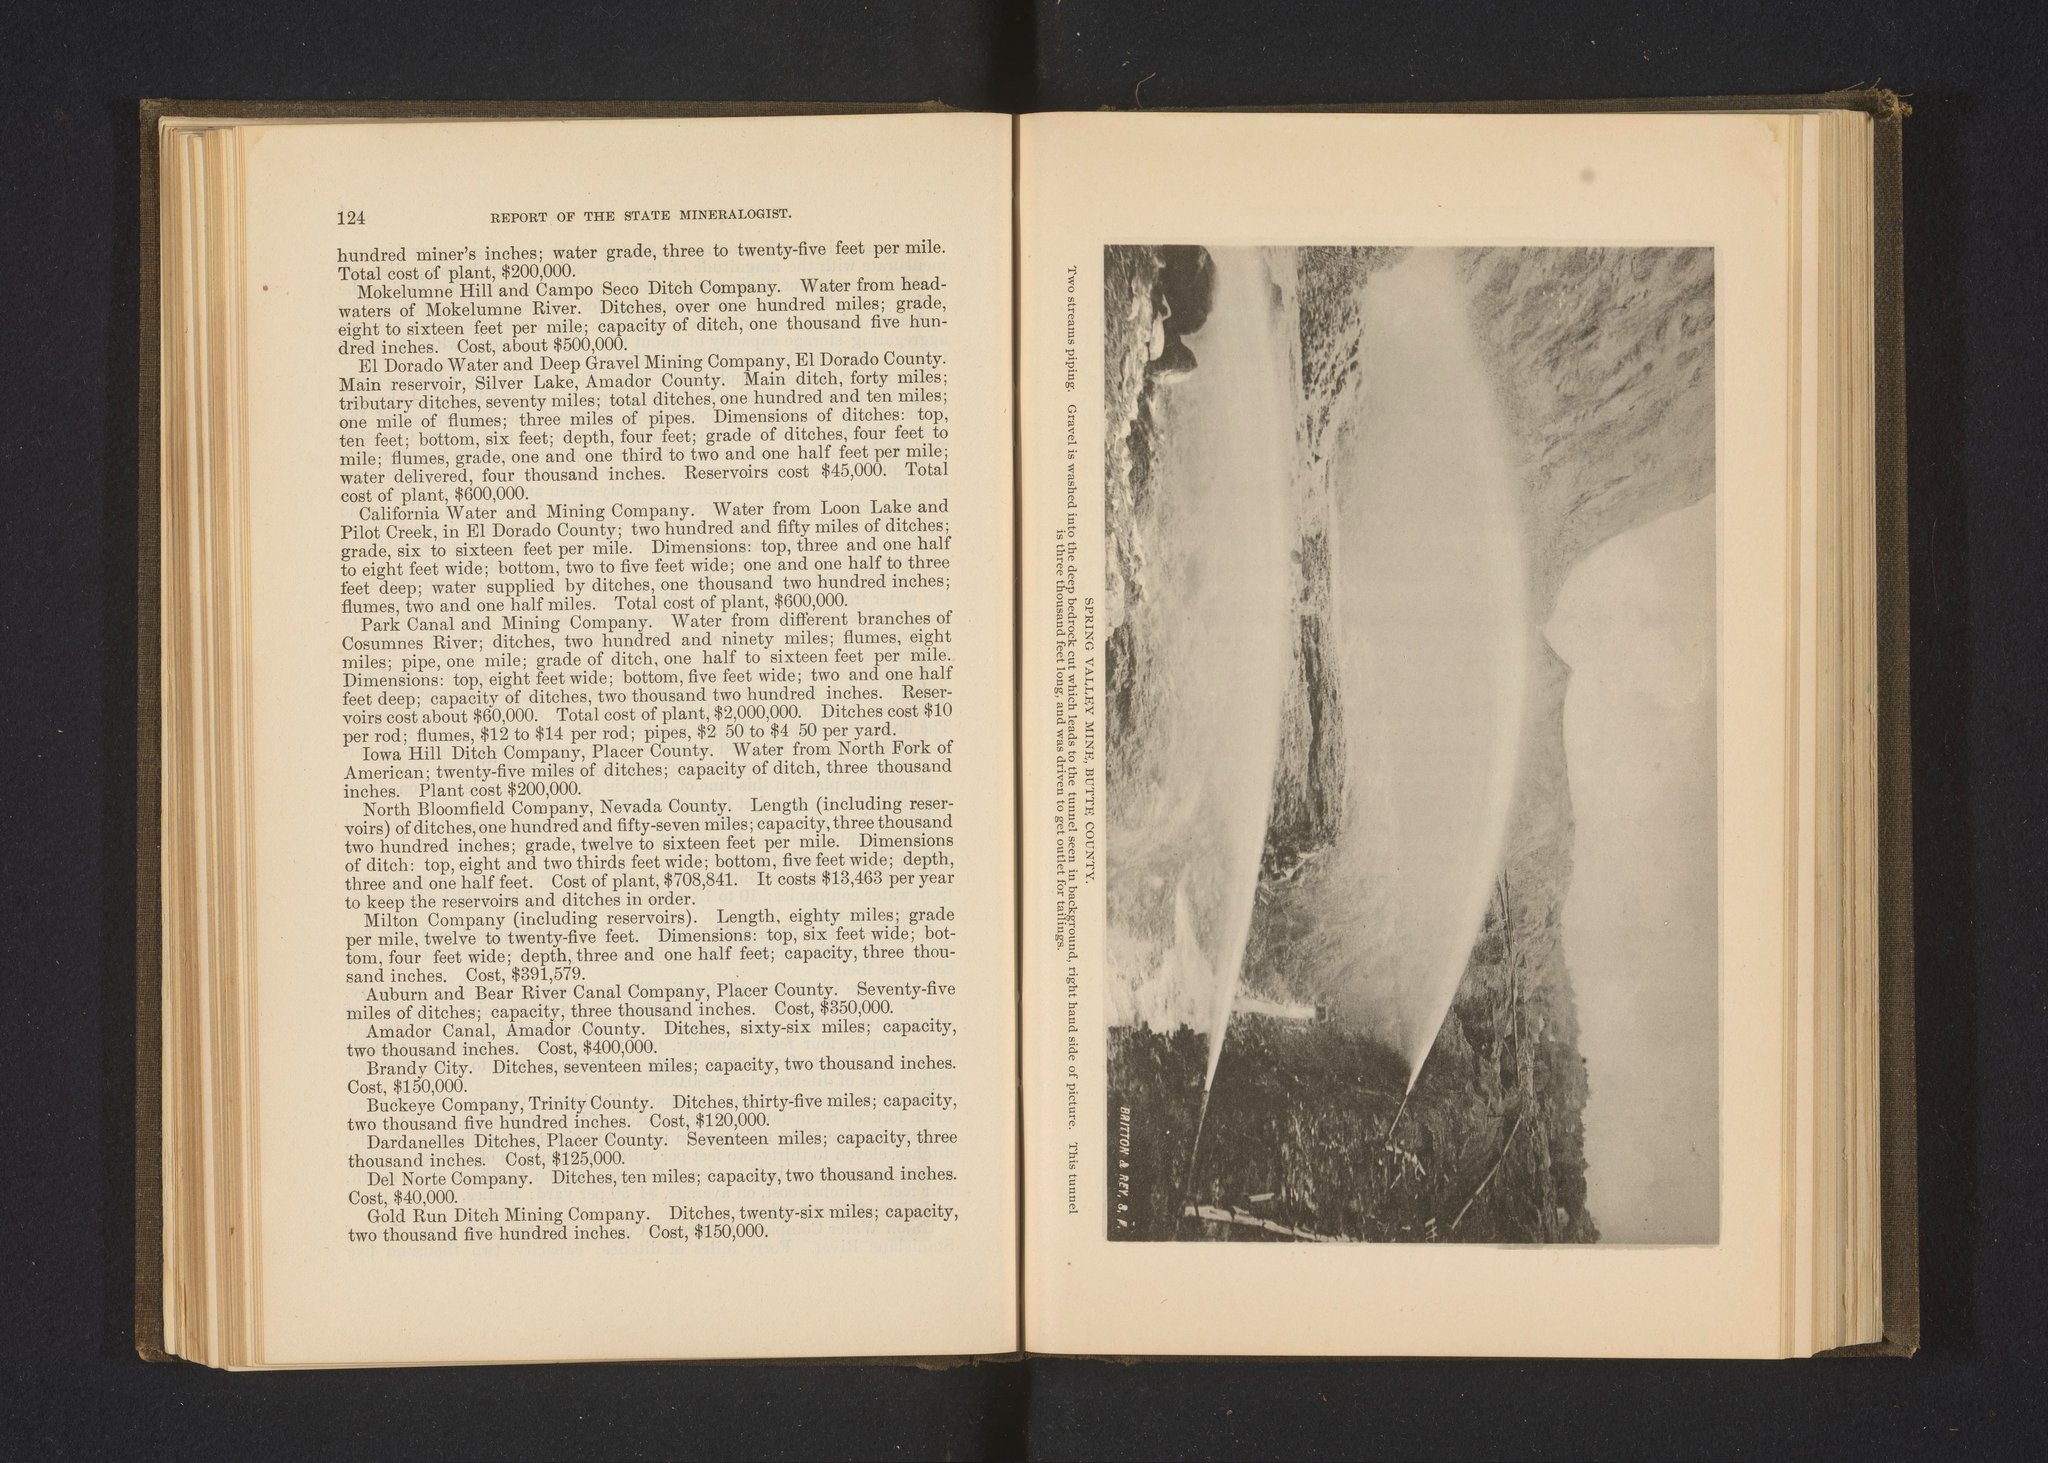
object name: photomechanical print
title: Spring Valley Mine, Butte County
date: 1885-1890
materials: paper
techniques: photograph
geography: butte county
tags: mine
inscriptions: inscription: ‘Two streams piping. Gravel is washed into the deep bedrock cut which leads to the tunnel seen in background, right hand side of picture. This tunnel/ is three thousand feet long, and was driven to get outlet for tailings.’